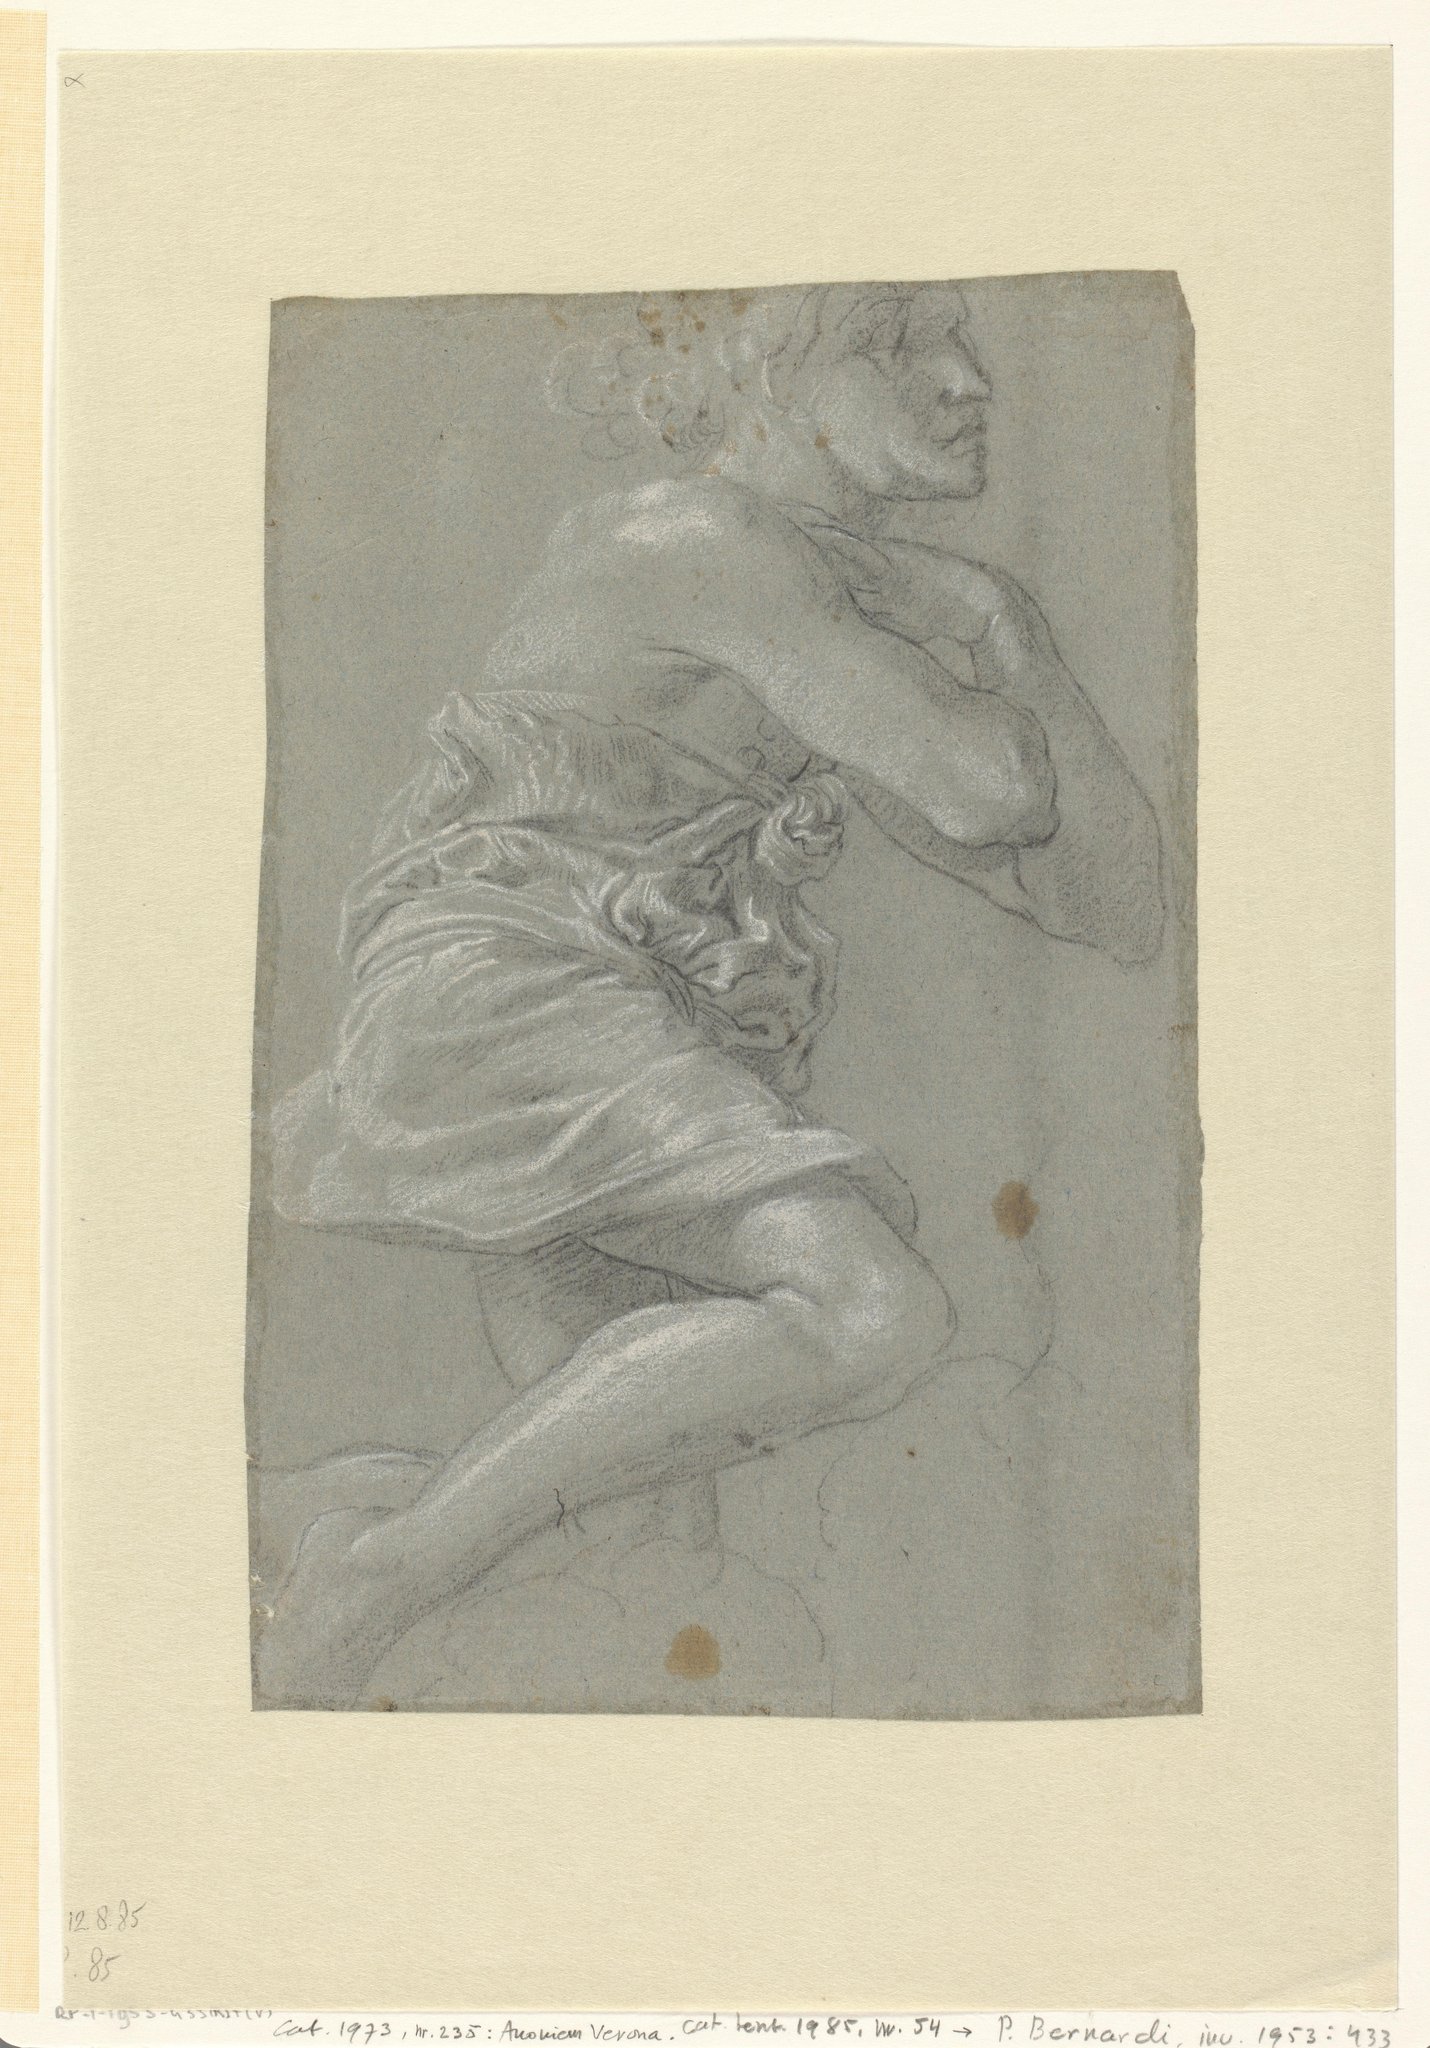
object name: drawing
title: Schetsbladen met figuurstudies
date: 1610-1630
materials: chalk, paper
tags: lower angel(s)